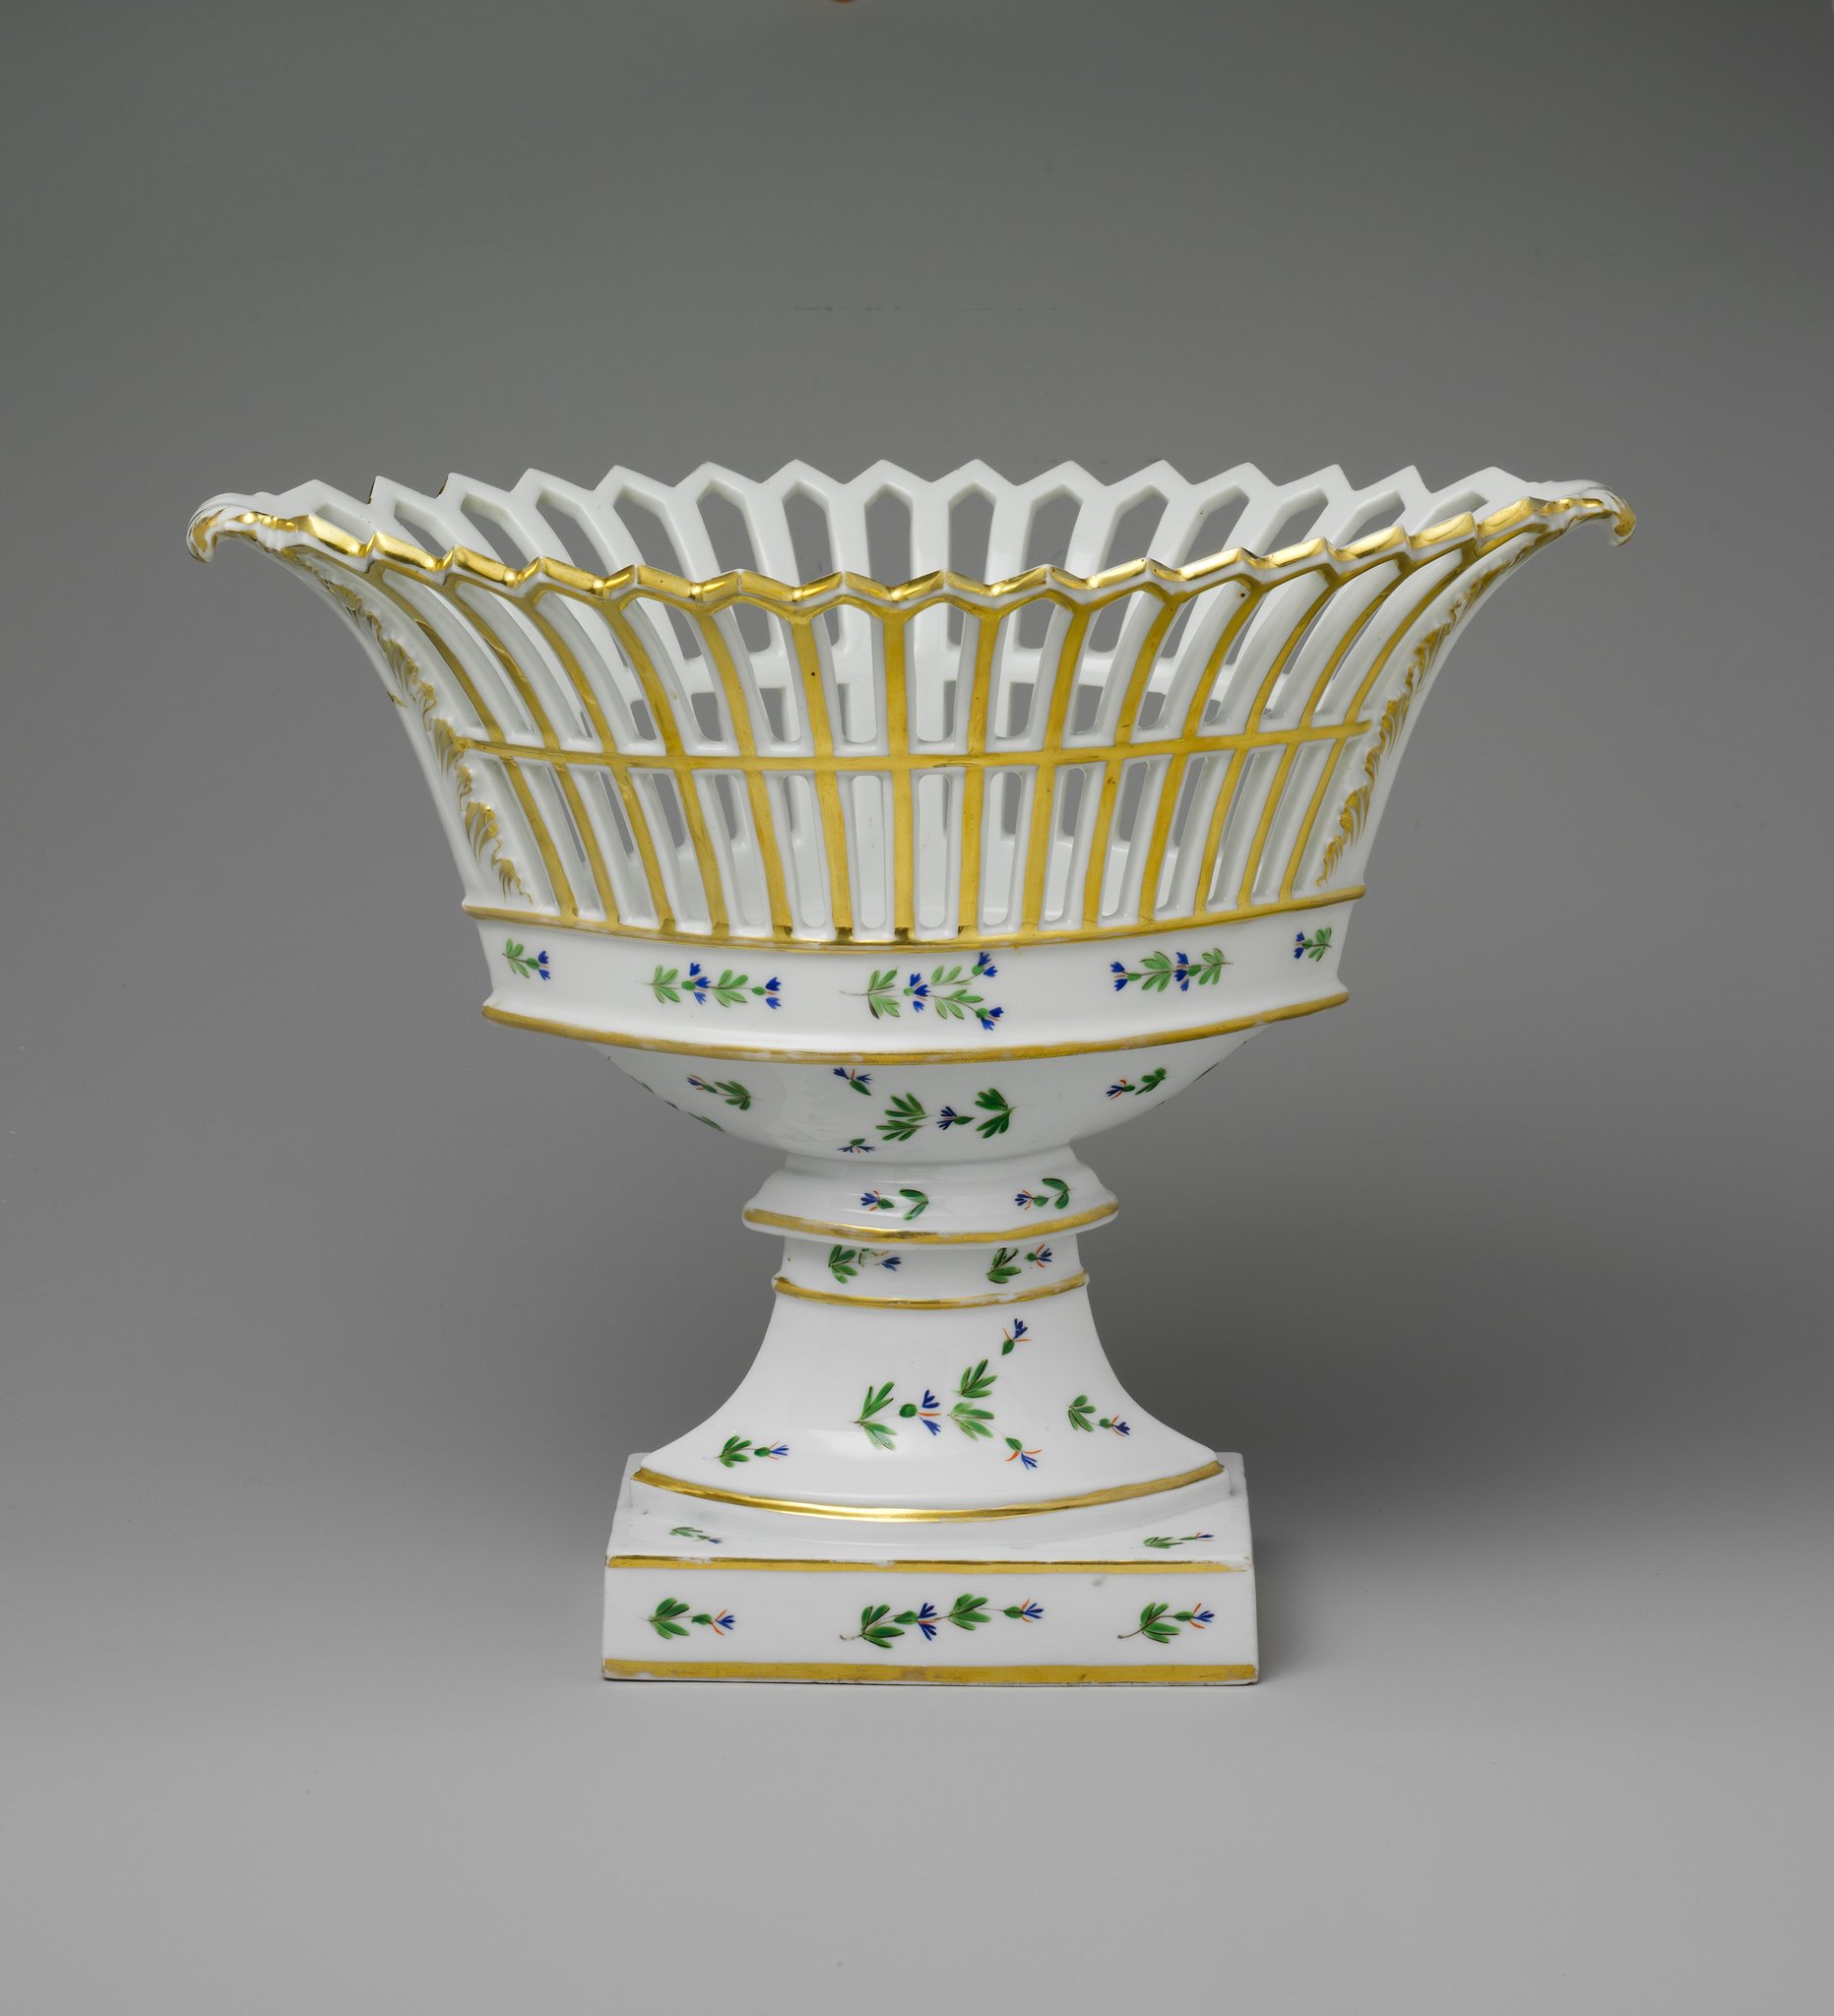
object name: compote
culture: french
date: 1815-1830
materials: porcelain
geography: france